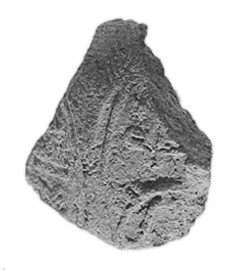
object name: sealing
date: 2030-1640 BCE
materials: clay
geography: egypt